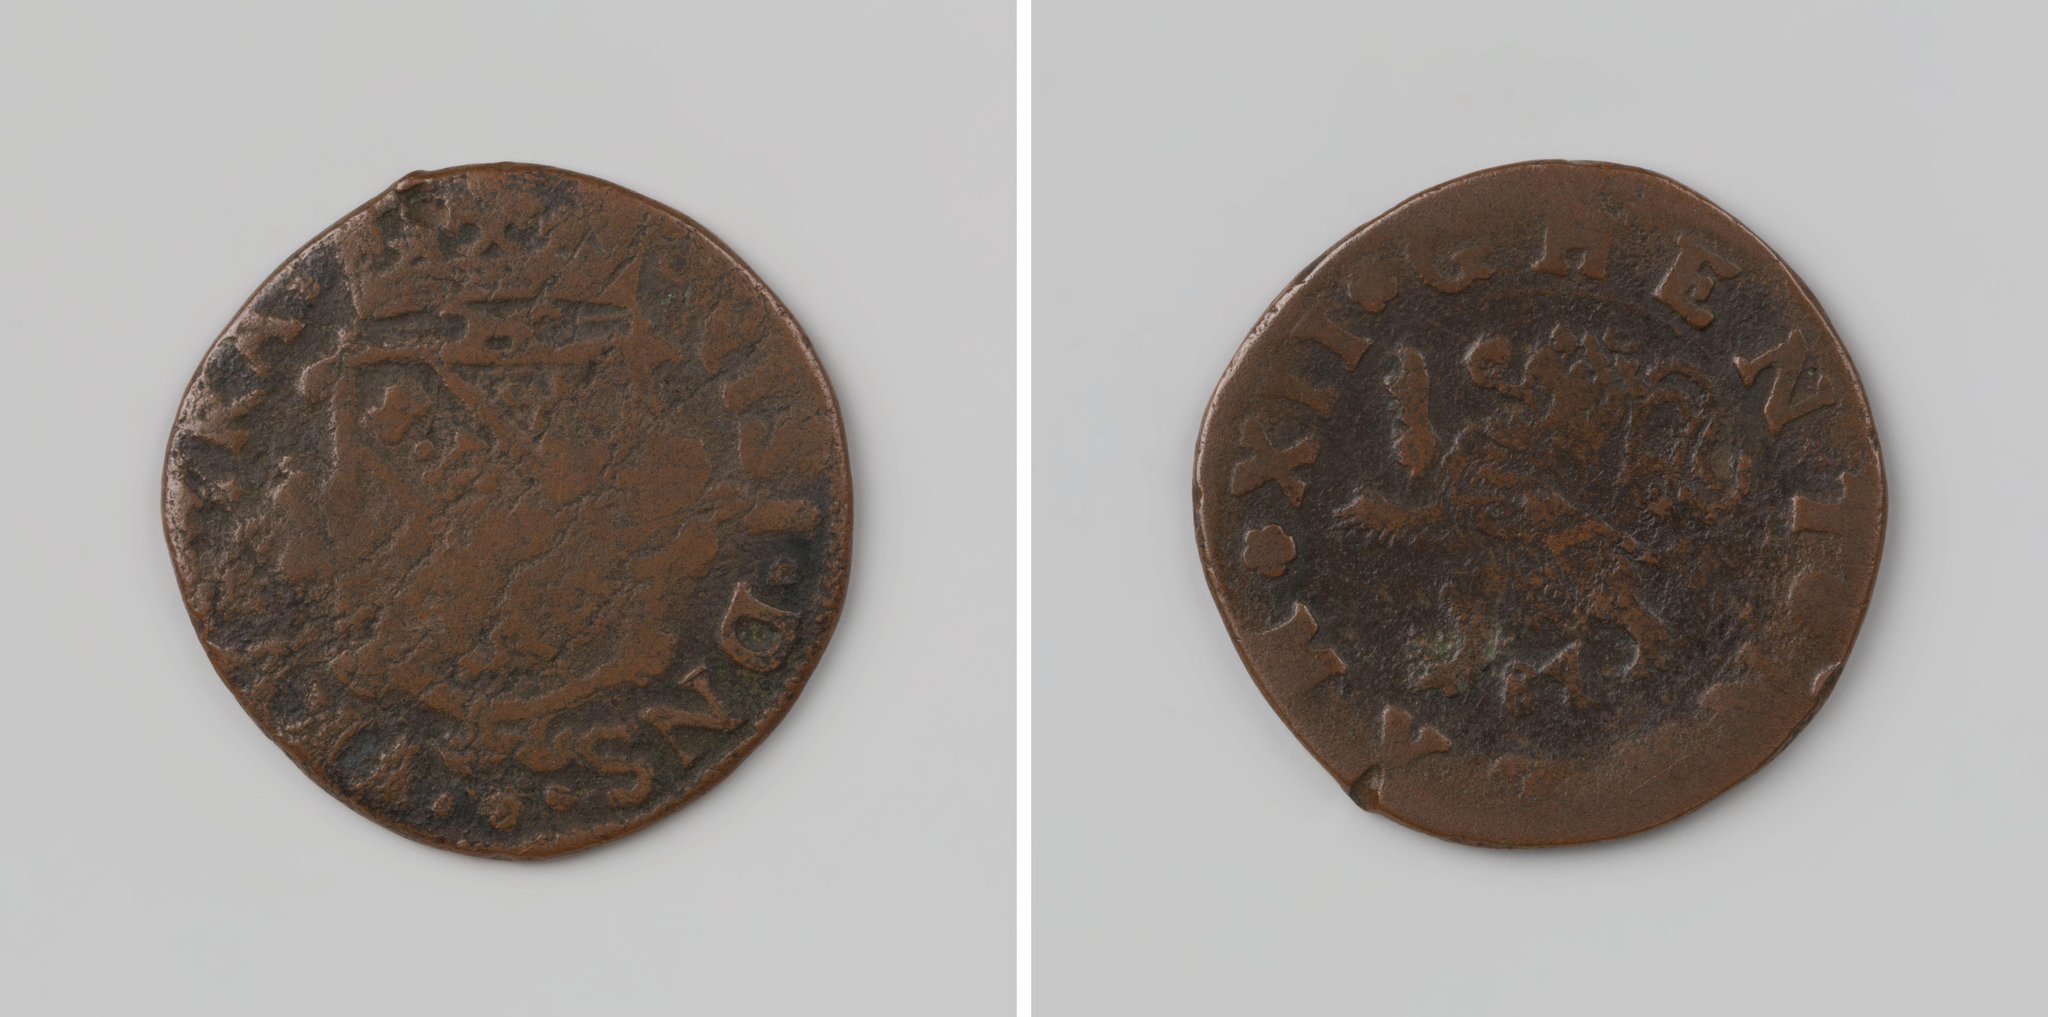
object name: coin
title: Vrije graafschap Vlaanderen, munt van twaalf mijten, geslagen te Gent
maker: Anonymous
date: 1584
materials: copper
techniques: striking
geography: ghent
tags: vlaanderen, tachtigjarige oorlog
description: Voorzijde: gekroonde, staande leeuw boven jaartal binnen omschrift. Keerzijde: gekroond wapenschild binnen omschrift